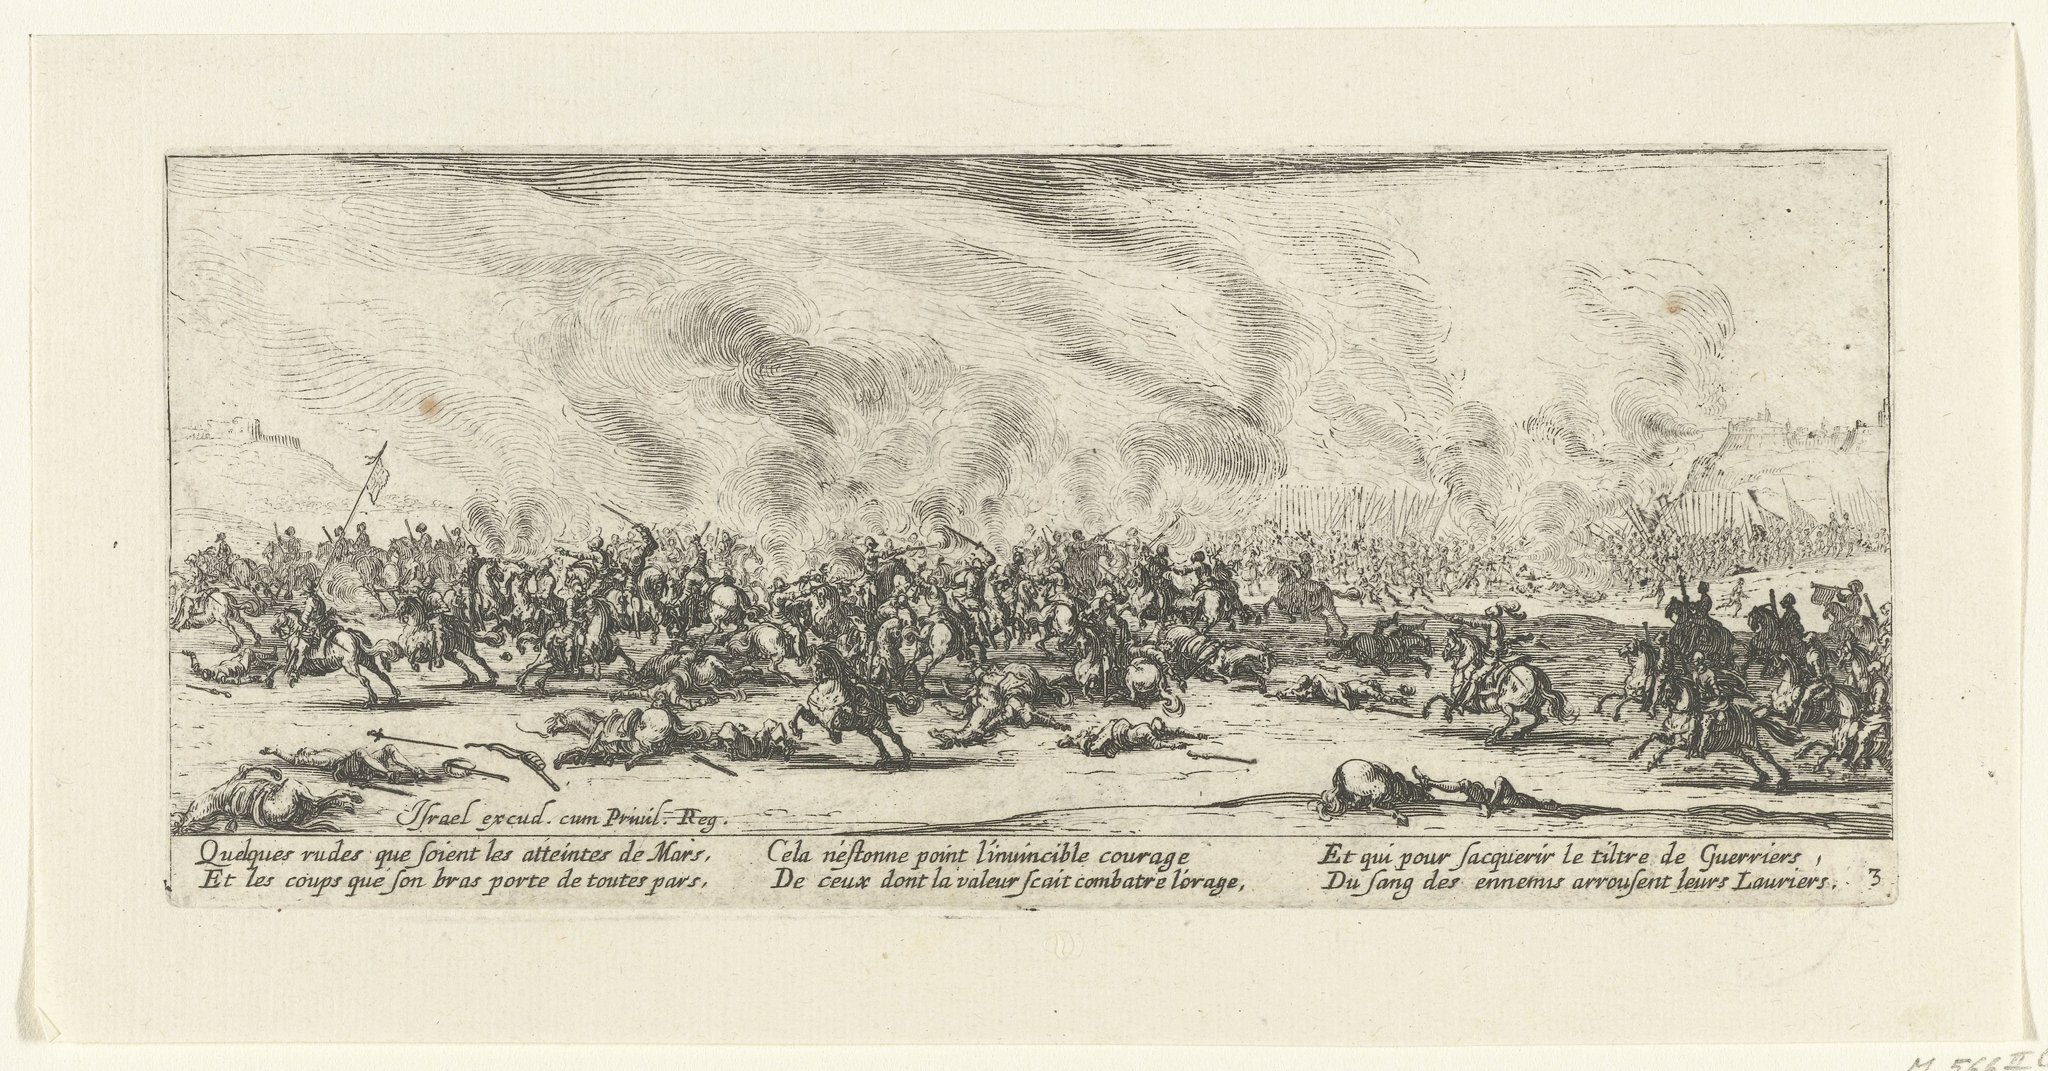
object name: print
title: Les miseres et les malheurs de la guerre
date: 1633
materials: paper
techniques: etching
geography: paris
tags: land forces, battle, warfare; military affairs (+ cavalry, horsemen), warfare; military affairs (+ infantry)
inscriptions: collector's mark: Lugt 240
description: Op een veld strijden vele ruiters met elkaar. Op de achtergrond is tevens een gevecht tussen infanteristen zichtbaar. Onder de voorstelling een zesregelig Frans vers. Deze prent is onderdeel van een serie van 17 (18 incl. titelprent) prenten met voorstellingen van diverse soorten ellende die oorlogvoering met zich meebrengt.